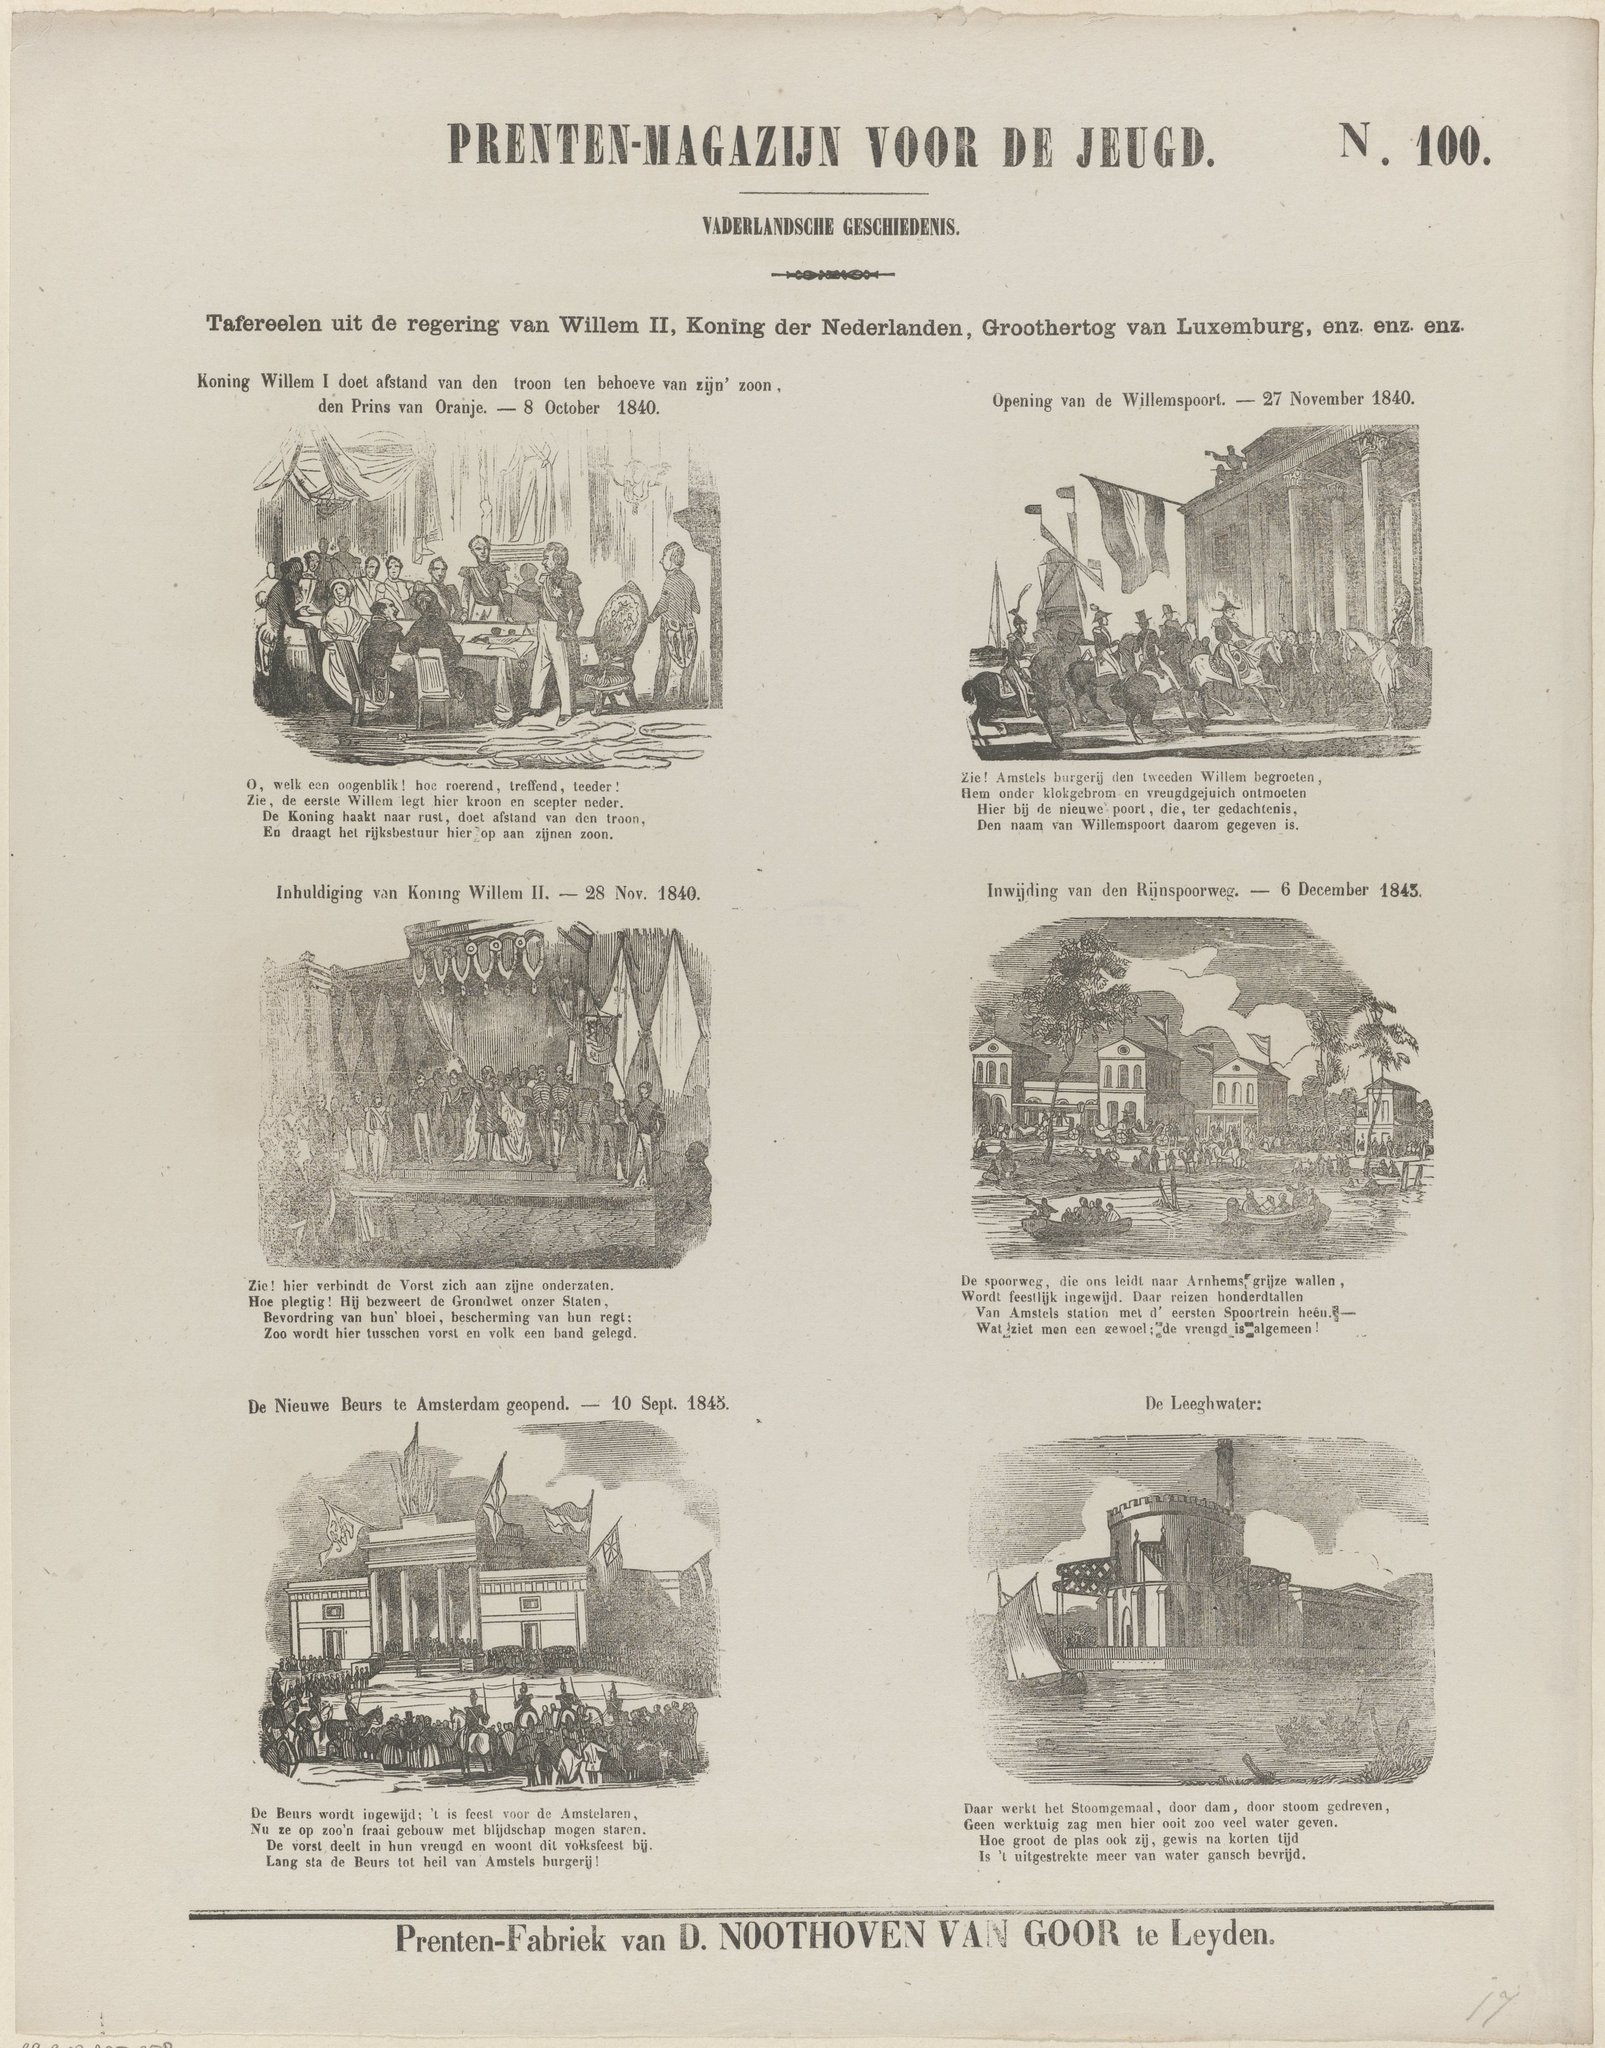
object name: print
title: Vaderlandsche geschiedenis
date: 1850-1881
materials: paper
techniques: letterpress printing, engraving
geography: leiden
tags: berlin, william i of the netherlands, the hague, william ii of the netherlands, history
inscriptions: collector's mark: Lugt 2228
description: Blad met 6 voorstellingen van gebeurtenissen ten tijde van de regering van Willem II tussen 1840 en 1848. Boven elke voorstelling een titel en onder elke voorstelling een vierregelig vers. Genummerd rechtsboven: No. 100.